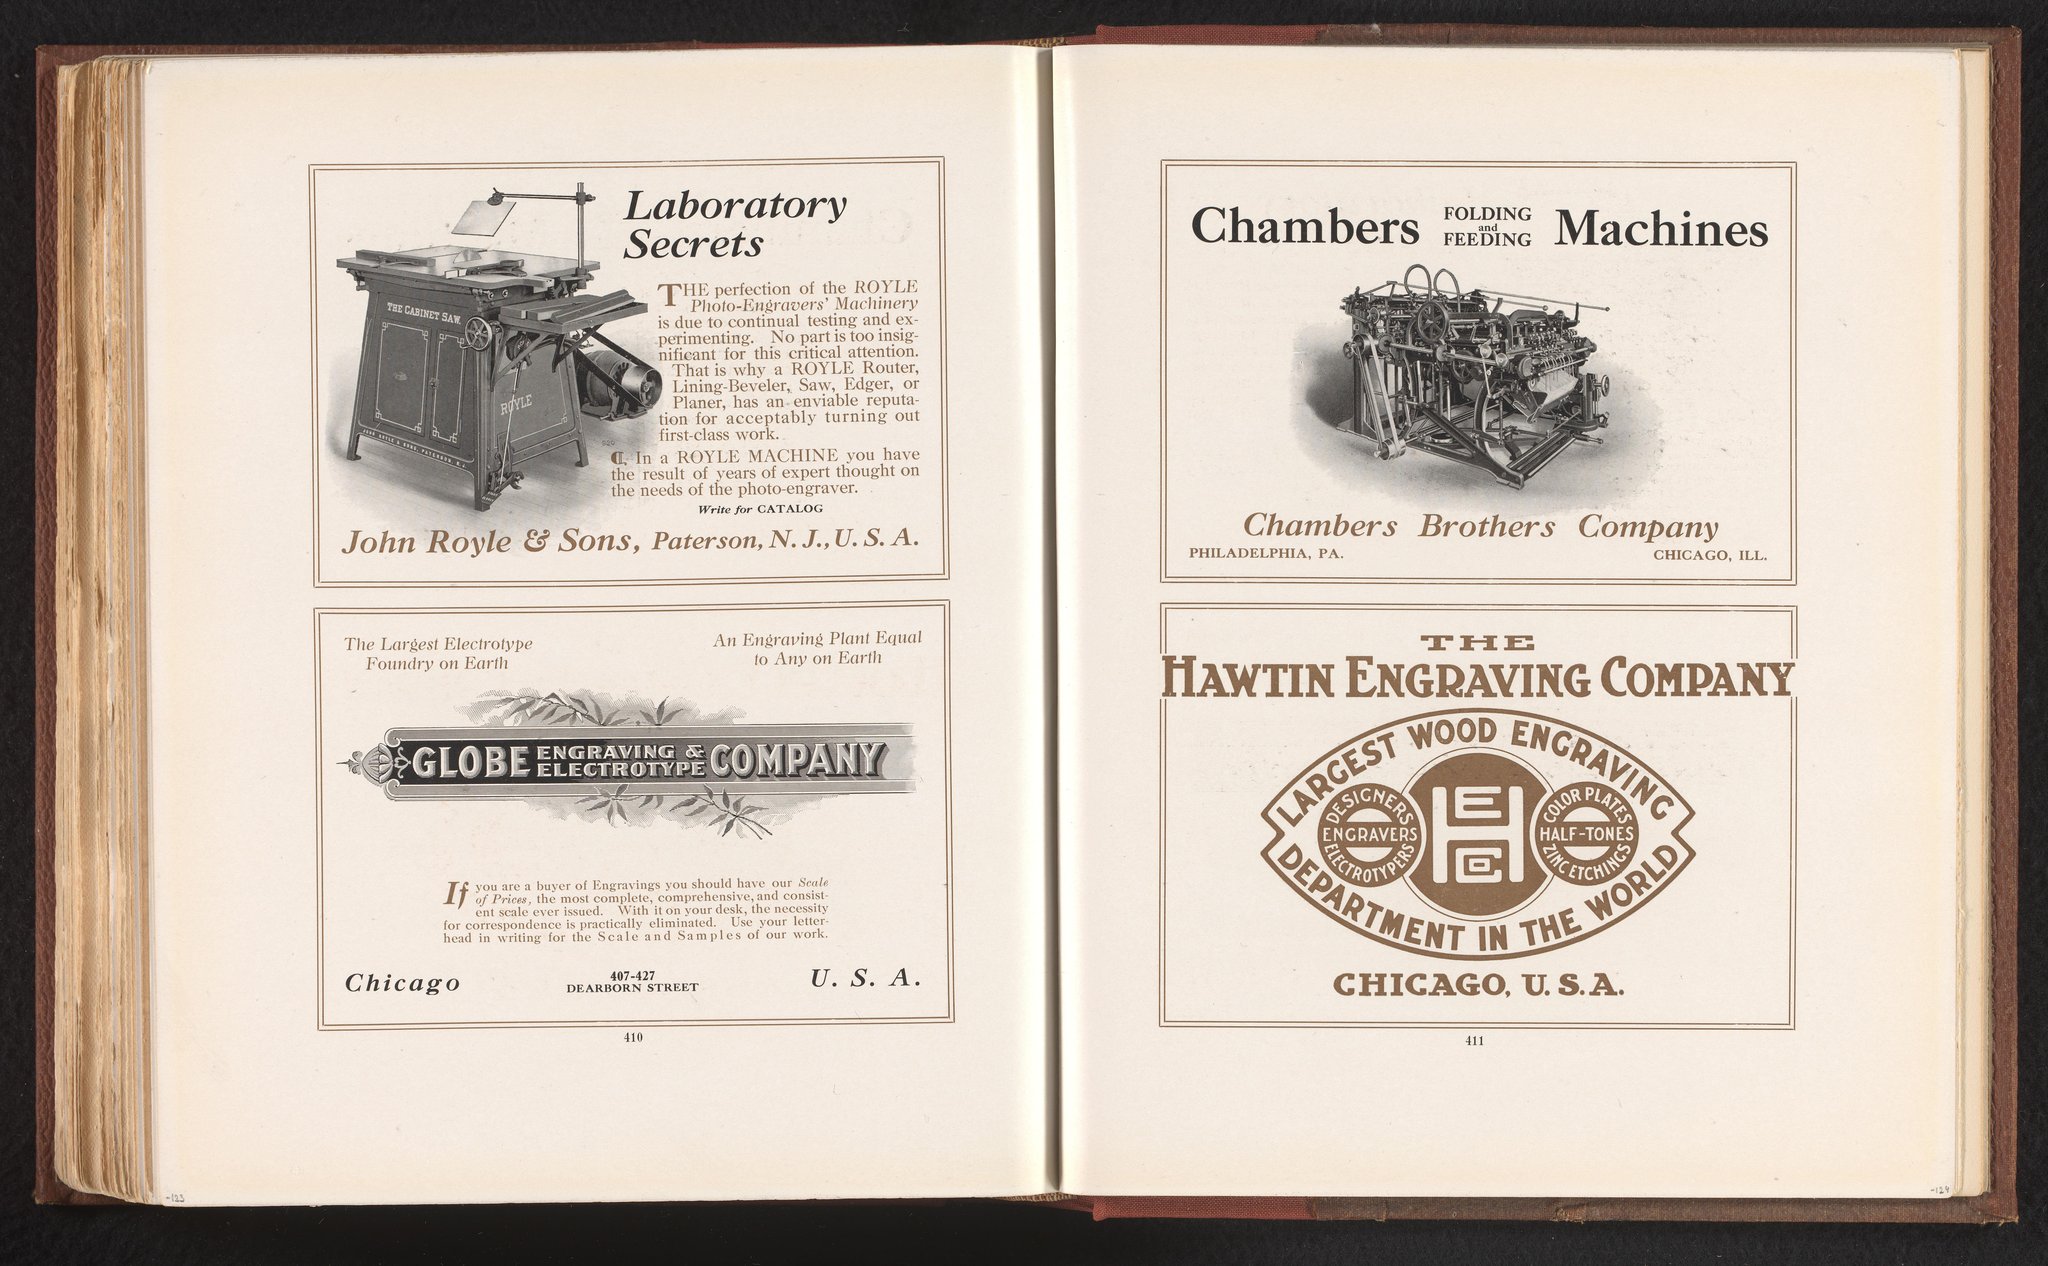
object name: photomechanical print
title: Reclames voor John Royle & Sons in Paterson en Globe Engraving & Electrotype Company in Chicago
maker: Anonymous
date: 1904-1909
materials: paper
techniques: autotype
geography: chicago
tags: advertising, tools, implements of printer, tools, aids, implements ~ crafts and industries: saw